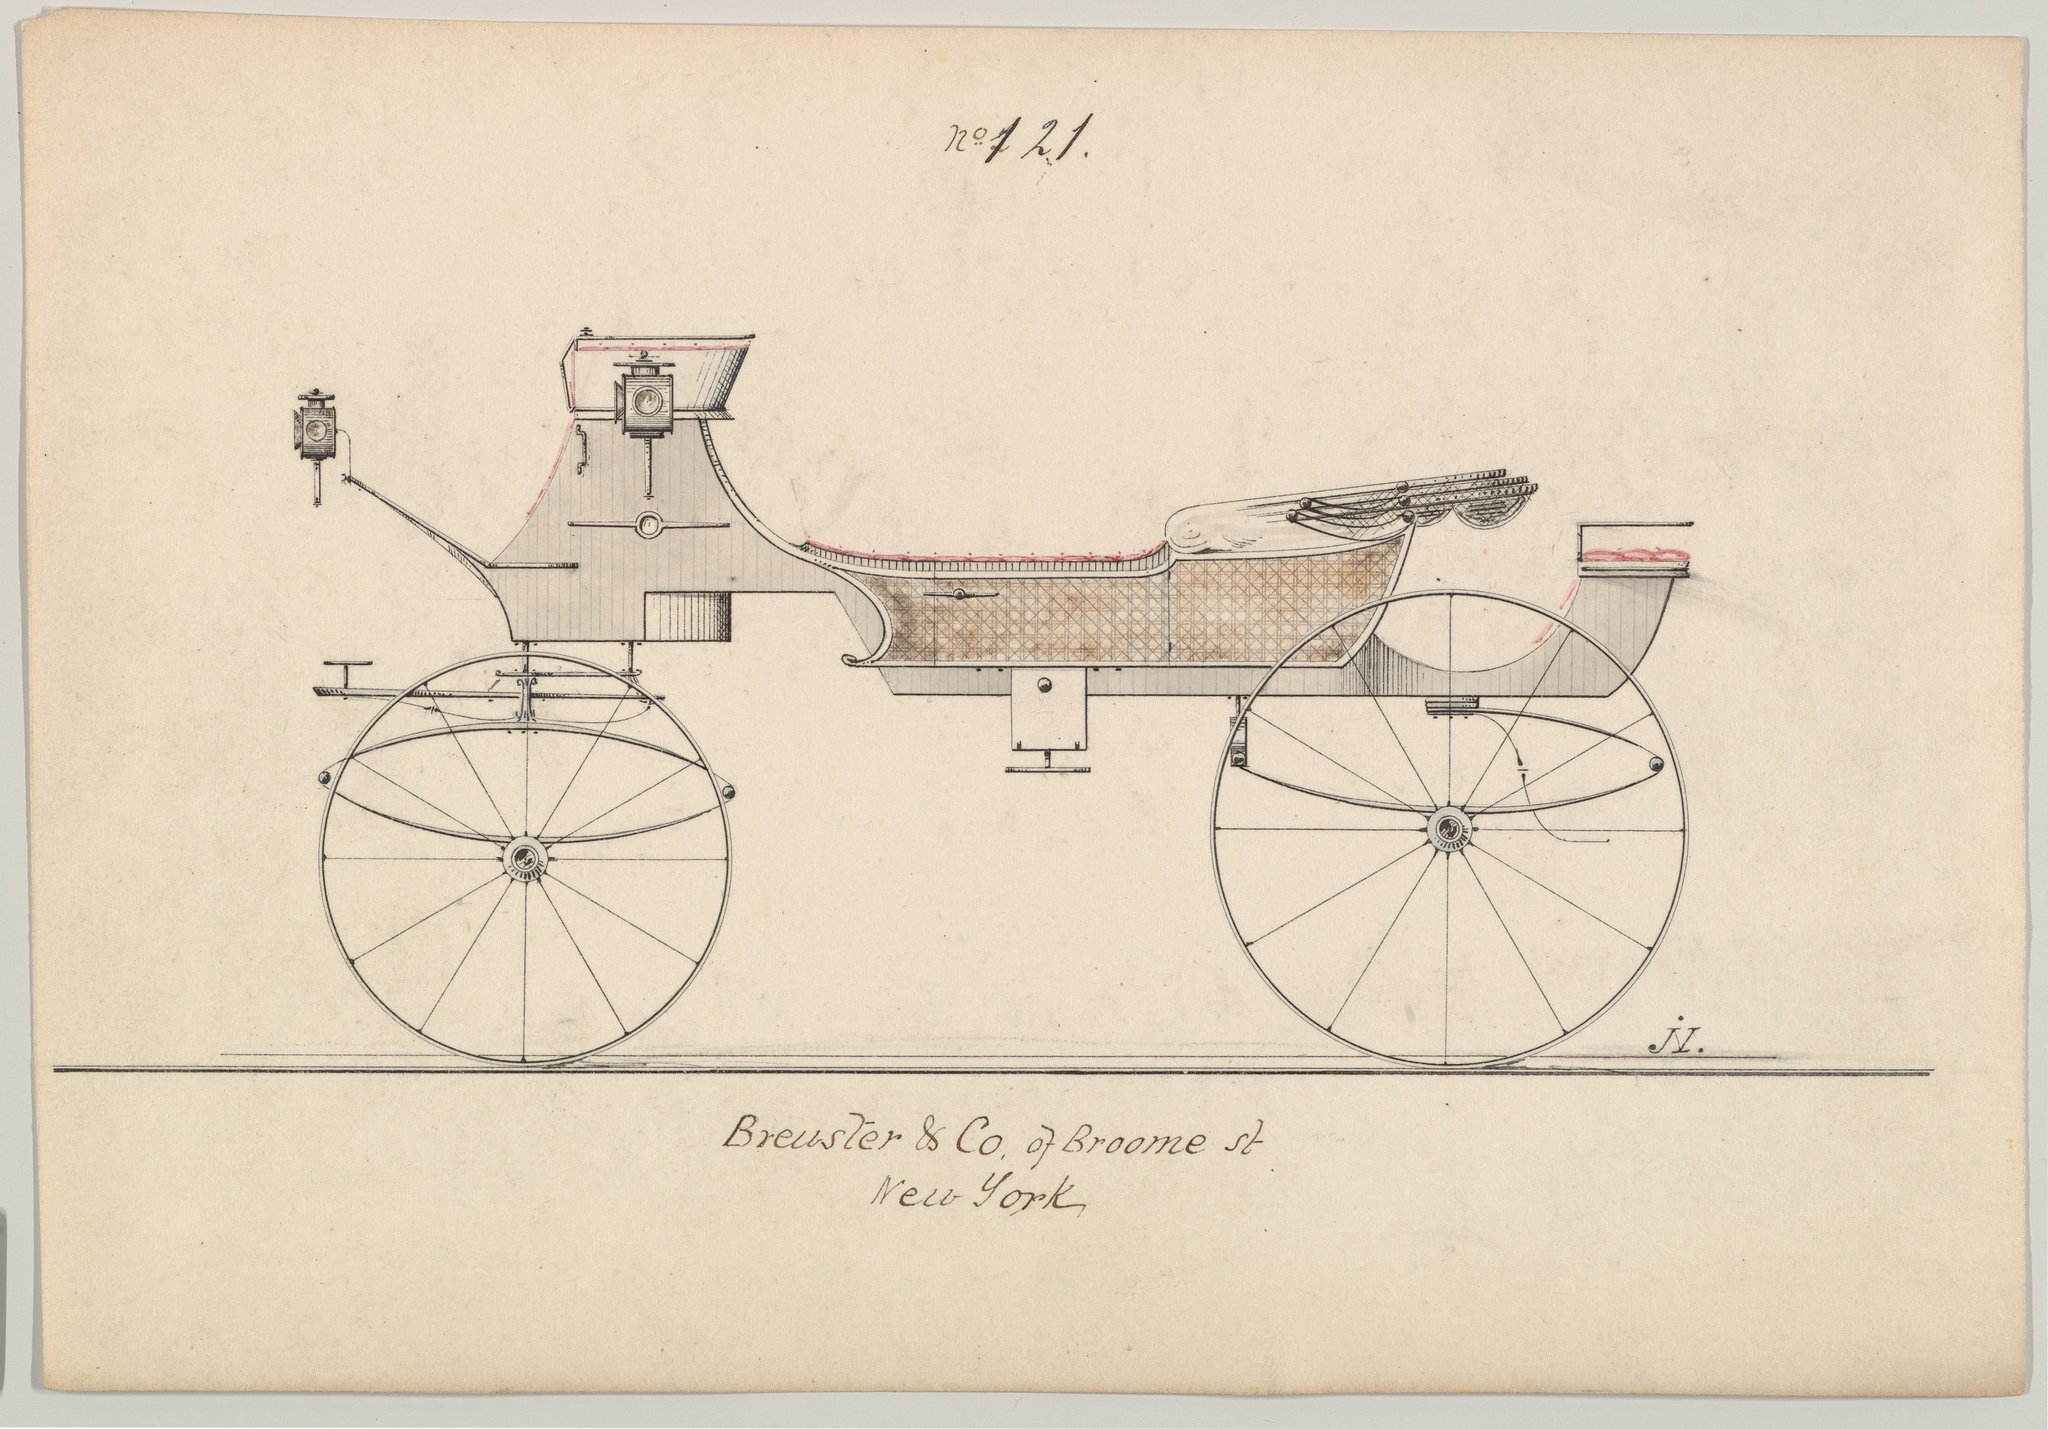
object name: drawing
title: Drag #121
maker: brewster & co.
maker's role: manufacturer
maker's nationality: american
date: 1865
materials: ink, watercolor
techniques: pen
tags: carriages